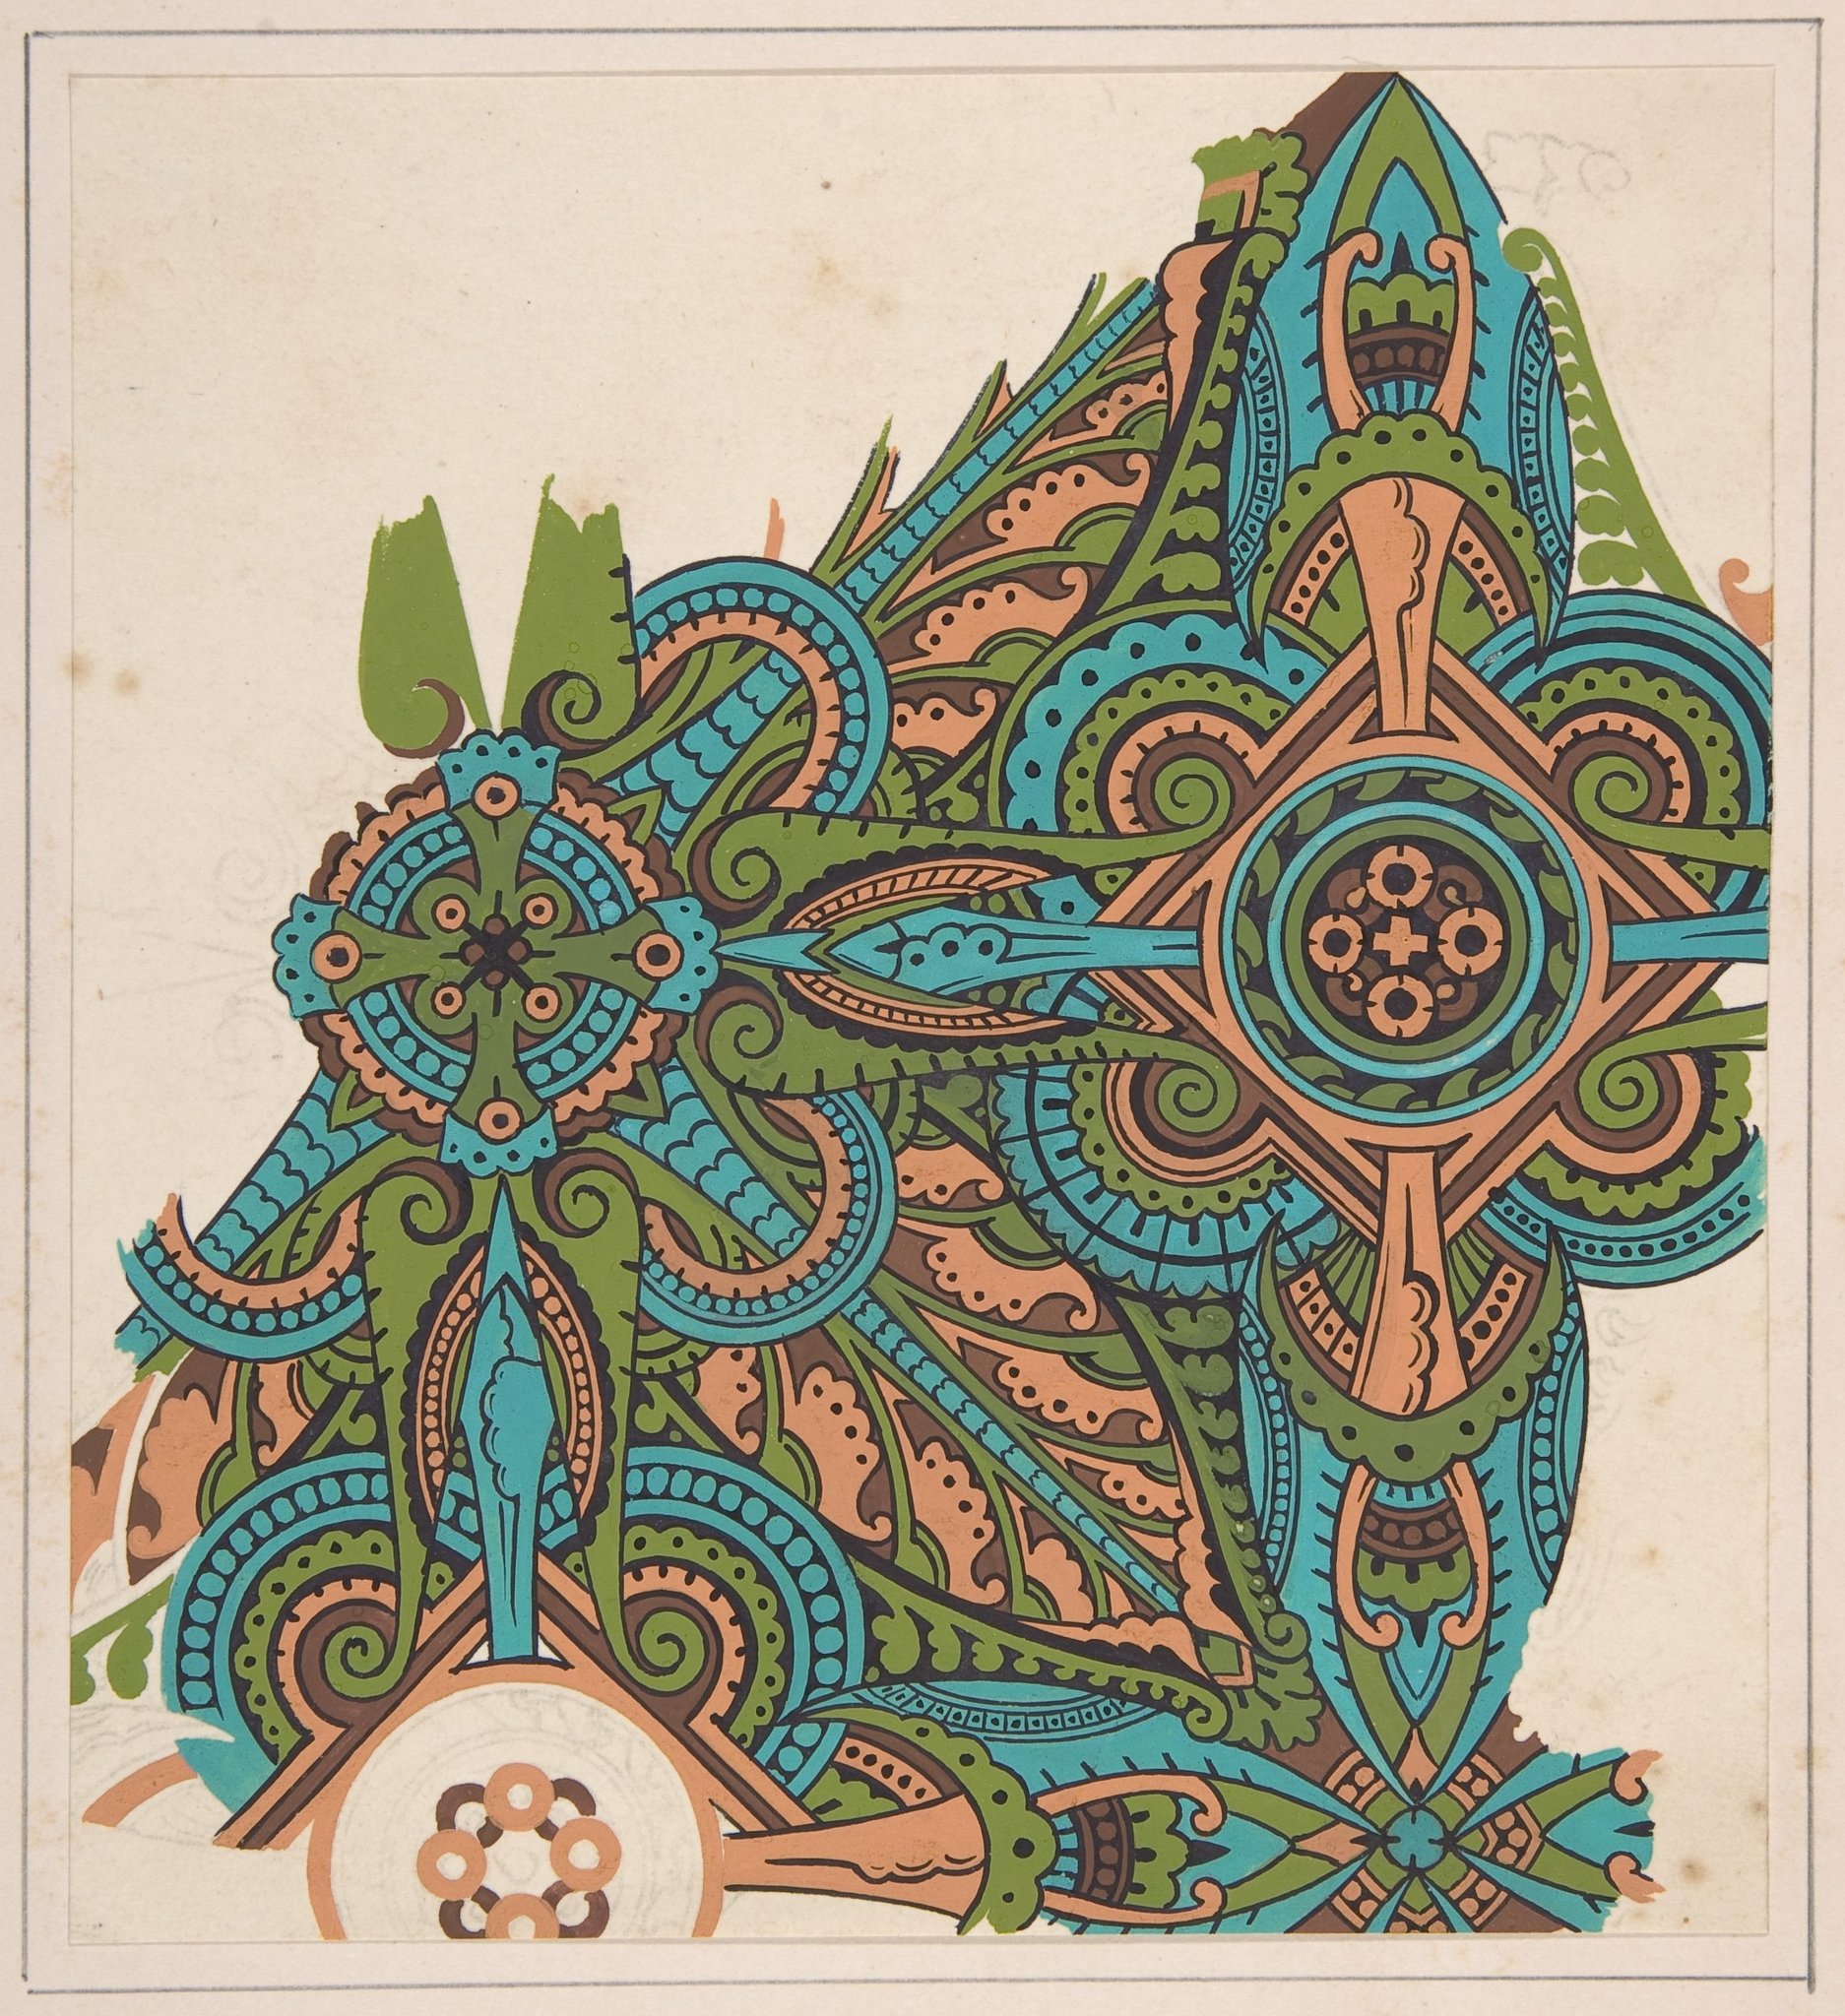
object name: drawing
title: Design drawing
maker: christopher dresser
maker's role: designer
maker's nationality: british, scottish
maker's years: 1834-1904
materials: gouache, graphite, ink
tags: ornament